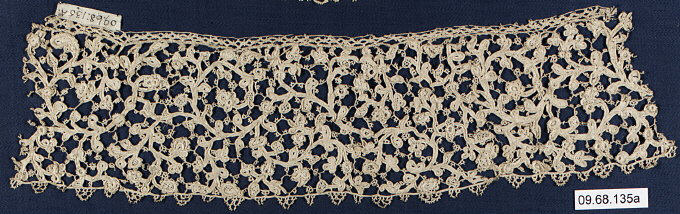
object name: cuff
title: Cuff (one of a pair)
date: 1601-1633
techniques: lace